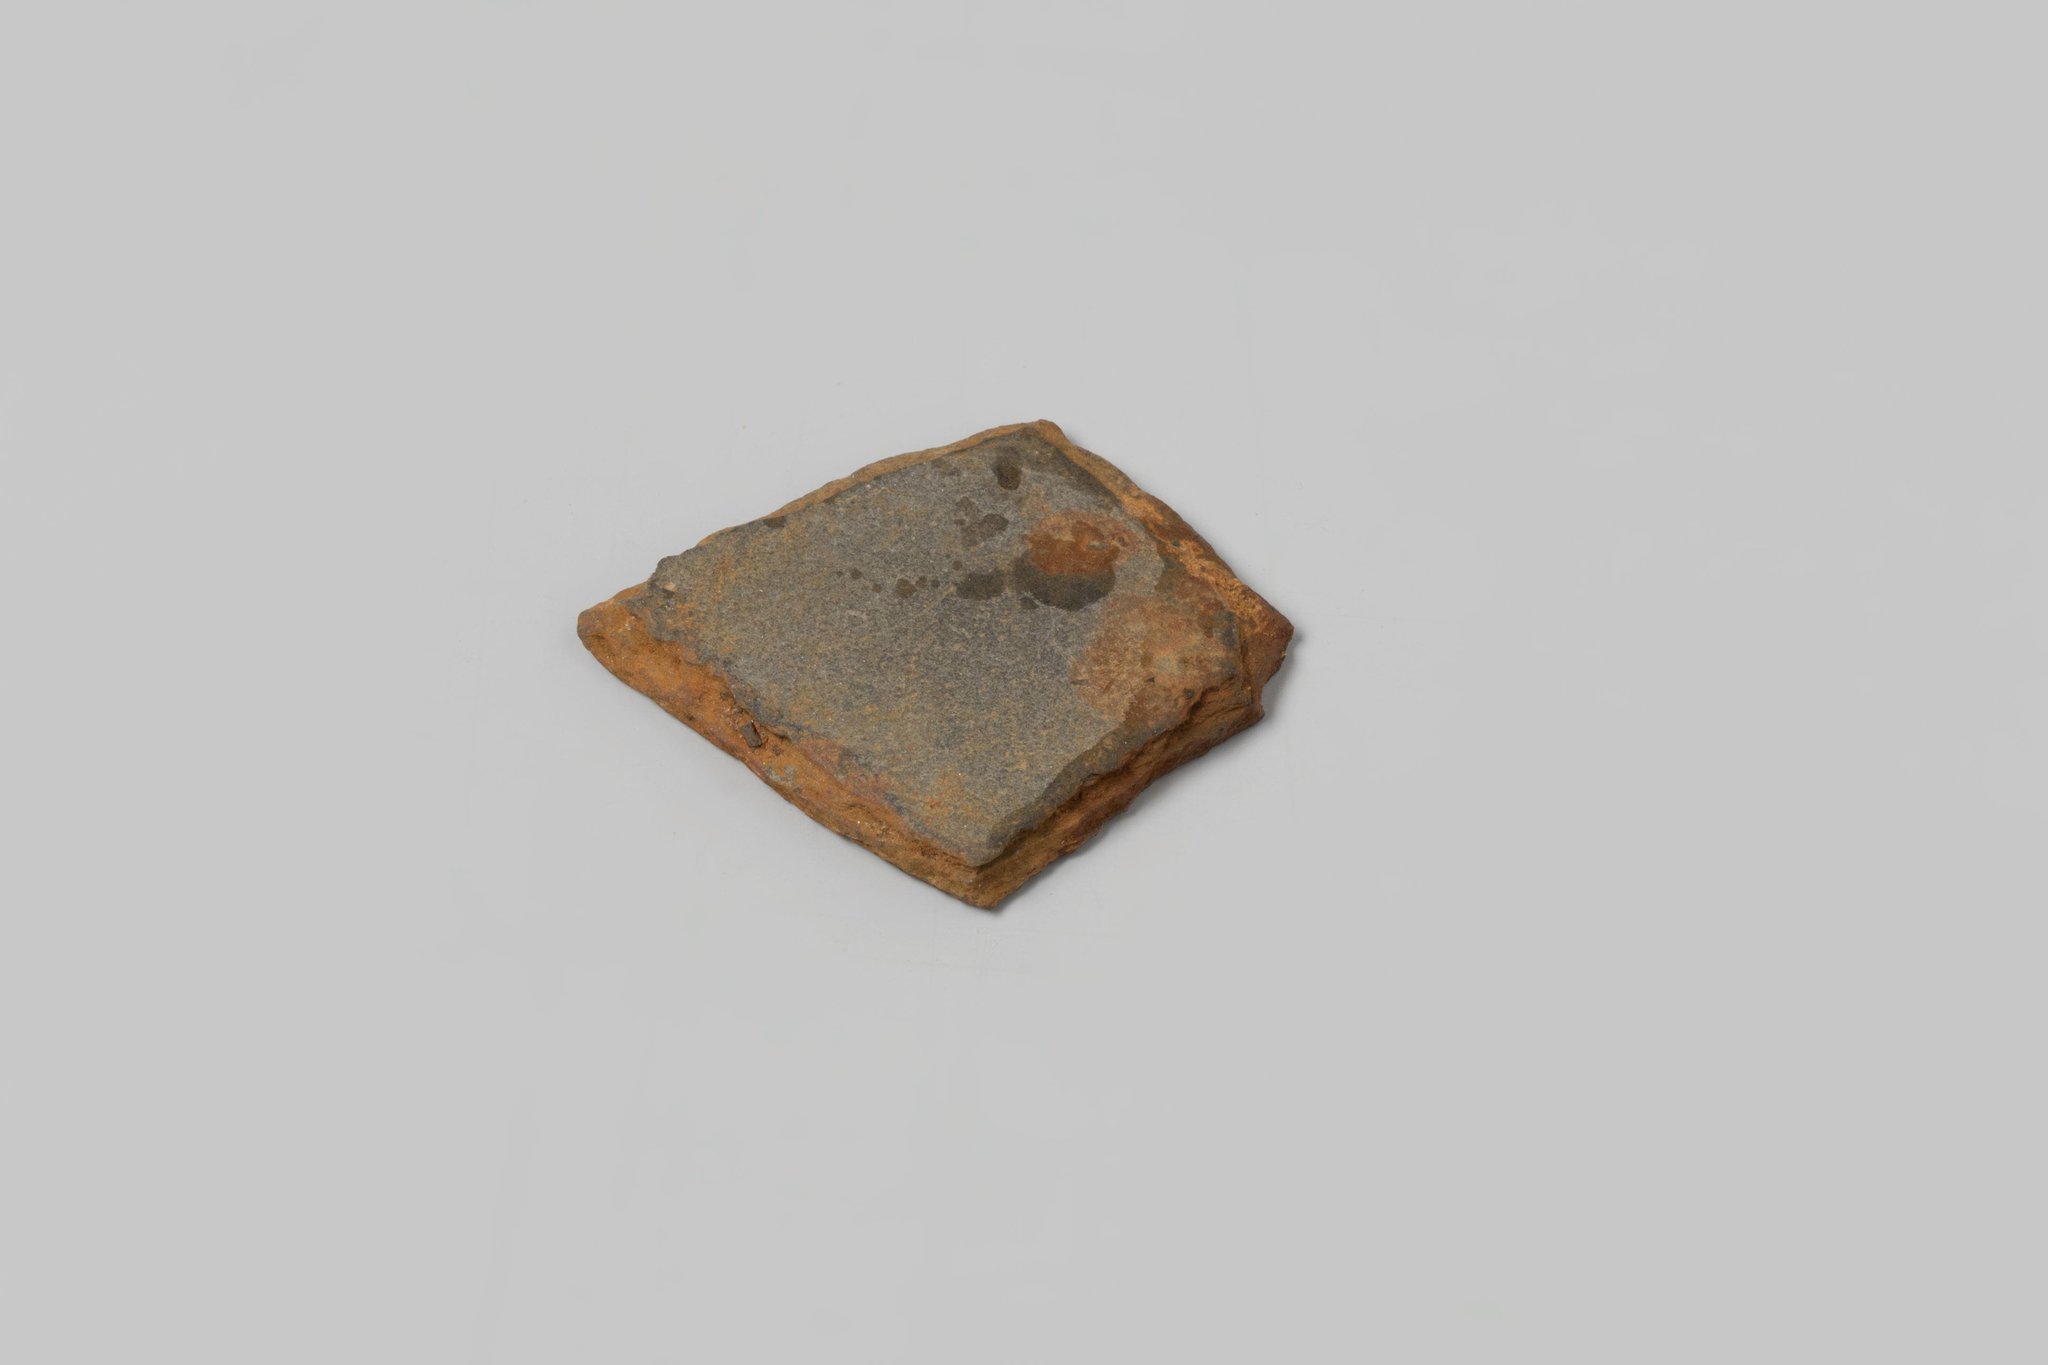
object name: scheepswrakvondst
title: Fragment leisteen uit het wrak van de Oost-Indiëvaarder Hollandia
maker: Anonymous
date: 1700-1743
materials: stone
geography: netherlands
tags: verenigde oostindische compagnie, hollandia (schip), annet